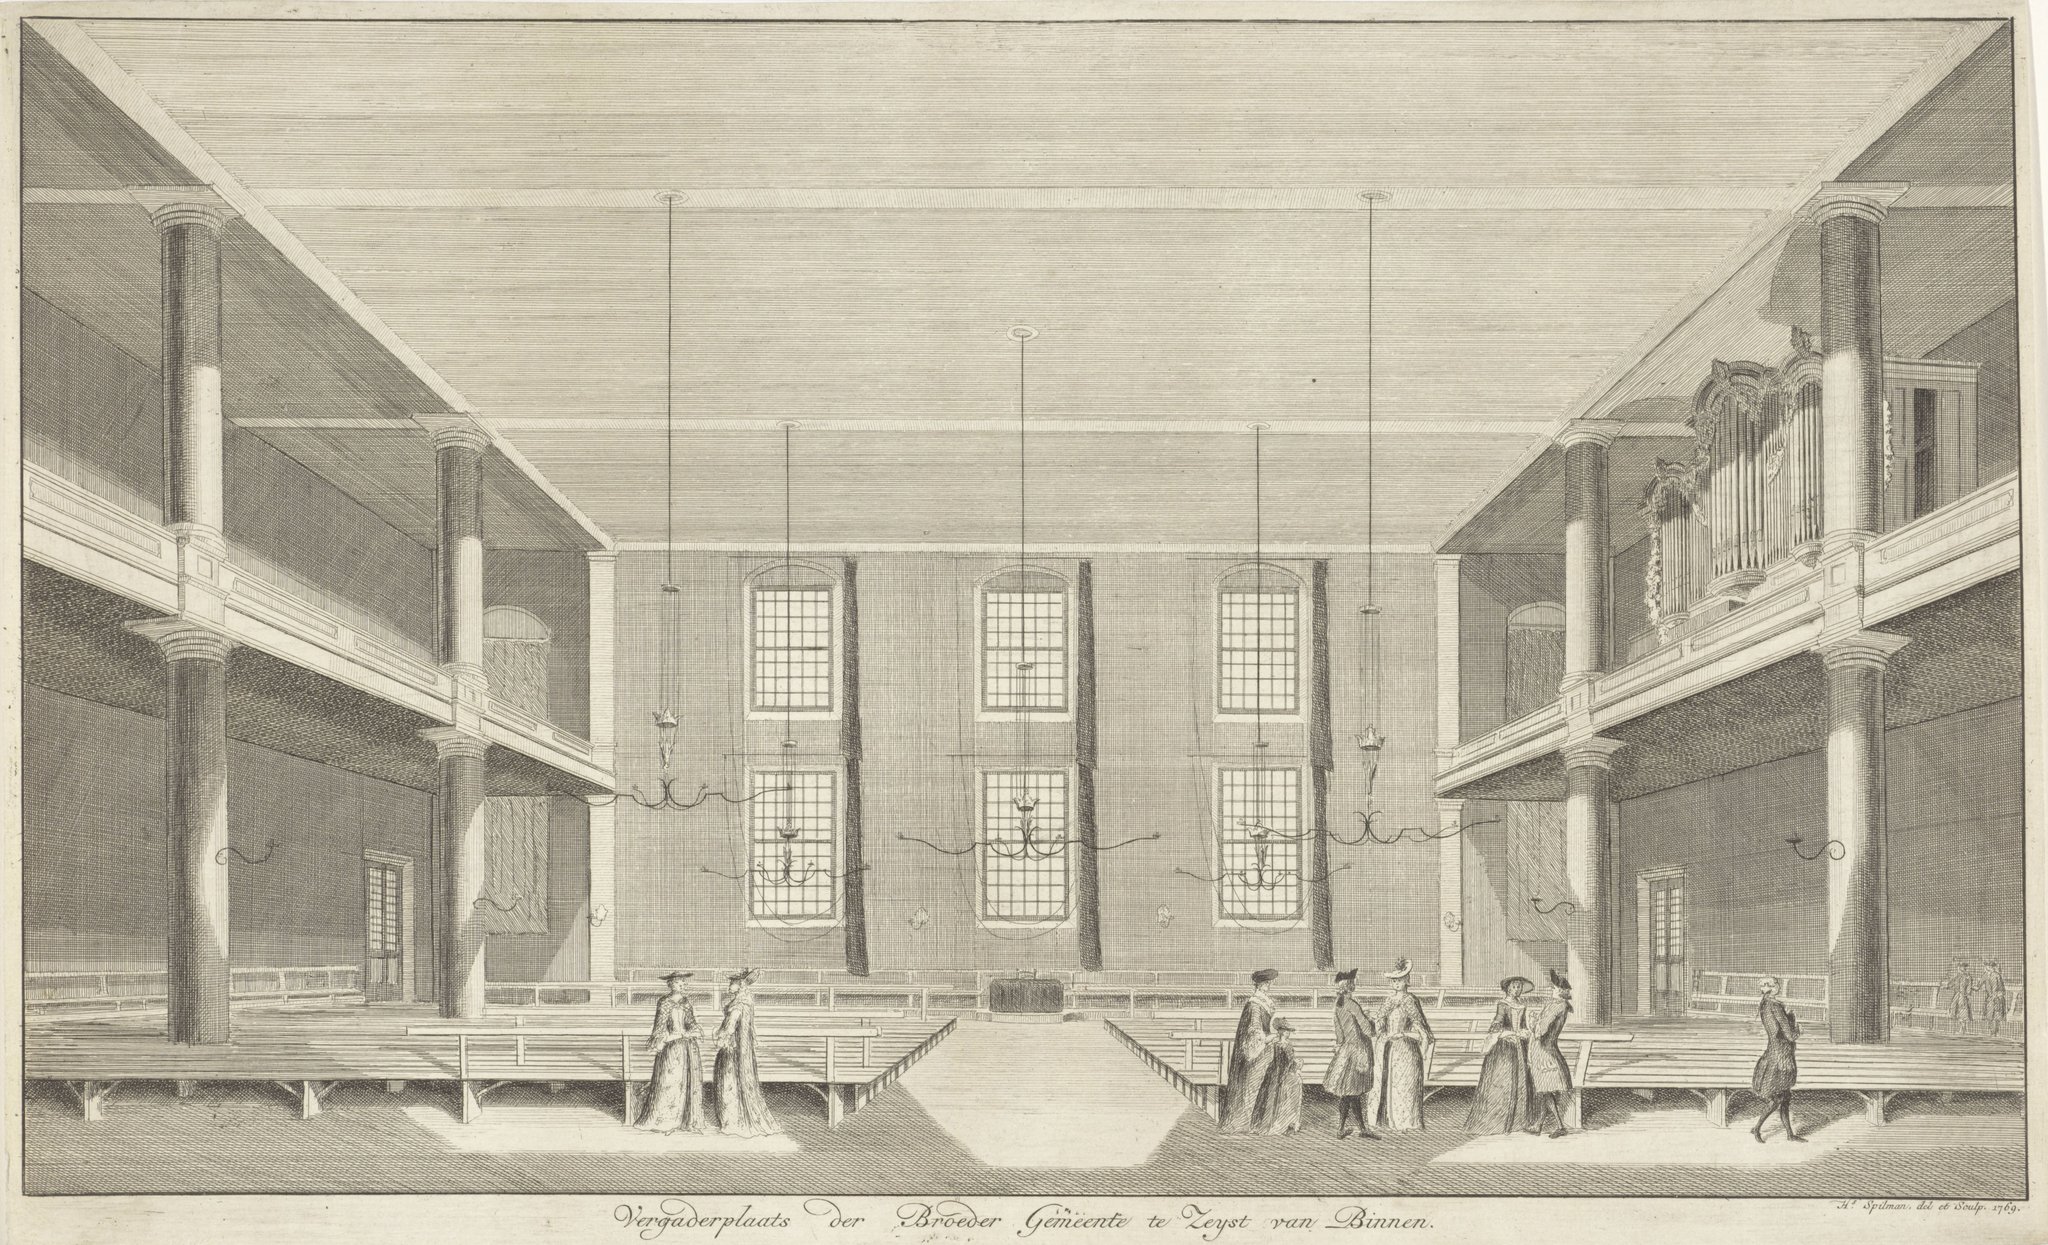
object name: print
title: Vergader Plaats der Broeder Gemeente te Zeyst van Binnen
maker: hendrik spilman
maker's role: draughtsman, painter, print maker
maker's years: 1721-1784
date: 1769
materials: paper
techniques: engraving, etching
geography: haarlem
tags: edifice, e.g.: public building, department store - aa - civic architecture: inside, edifice, e.g.: public building, department store, zeist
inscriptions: collector's mark: Lugt 2228